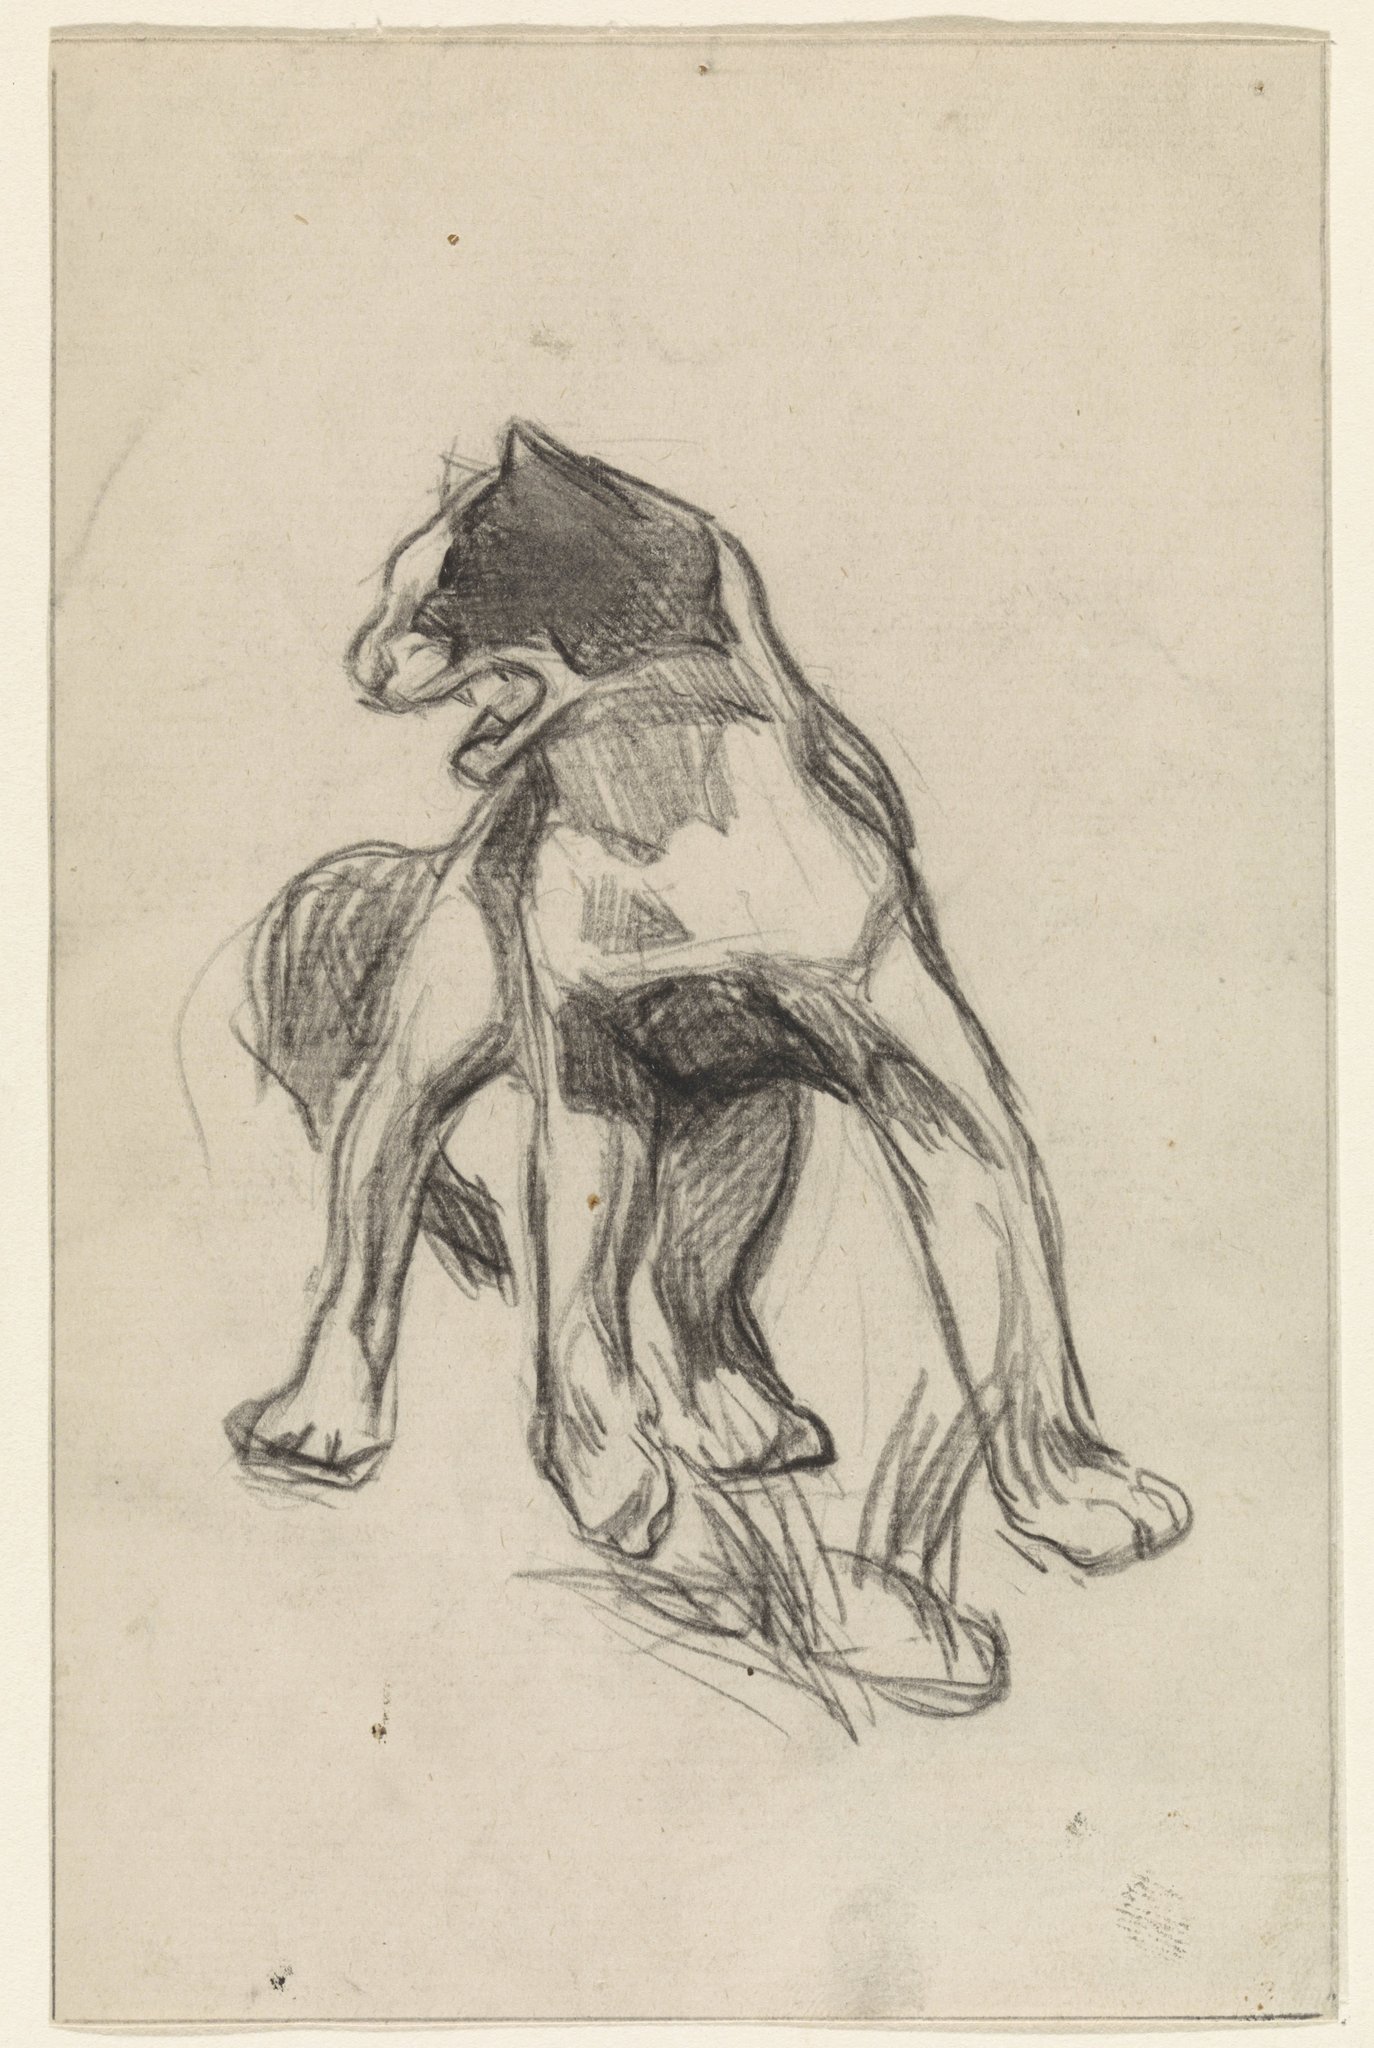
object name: drawing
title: Boze kat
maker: jan van essen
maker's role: draughtsman, print maker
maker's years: 1854-1936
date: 1864-1936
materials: chalk, paper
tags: cat